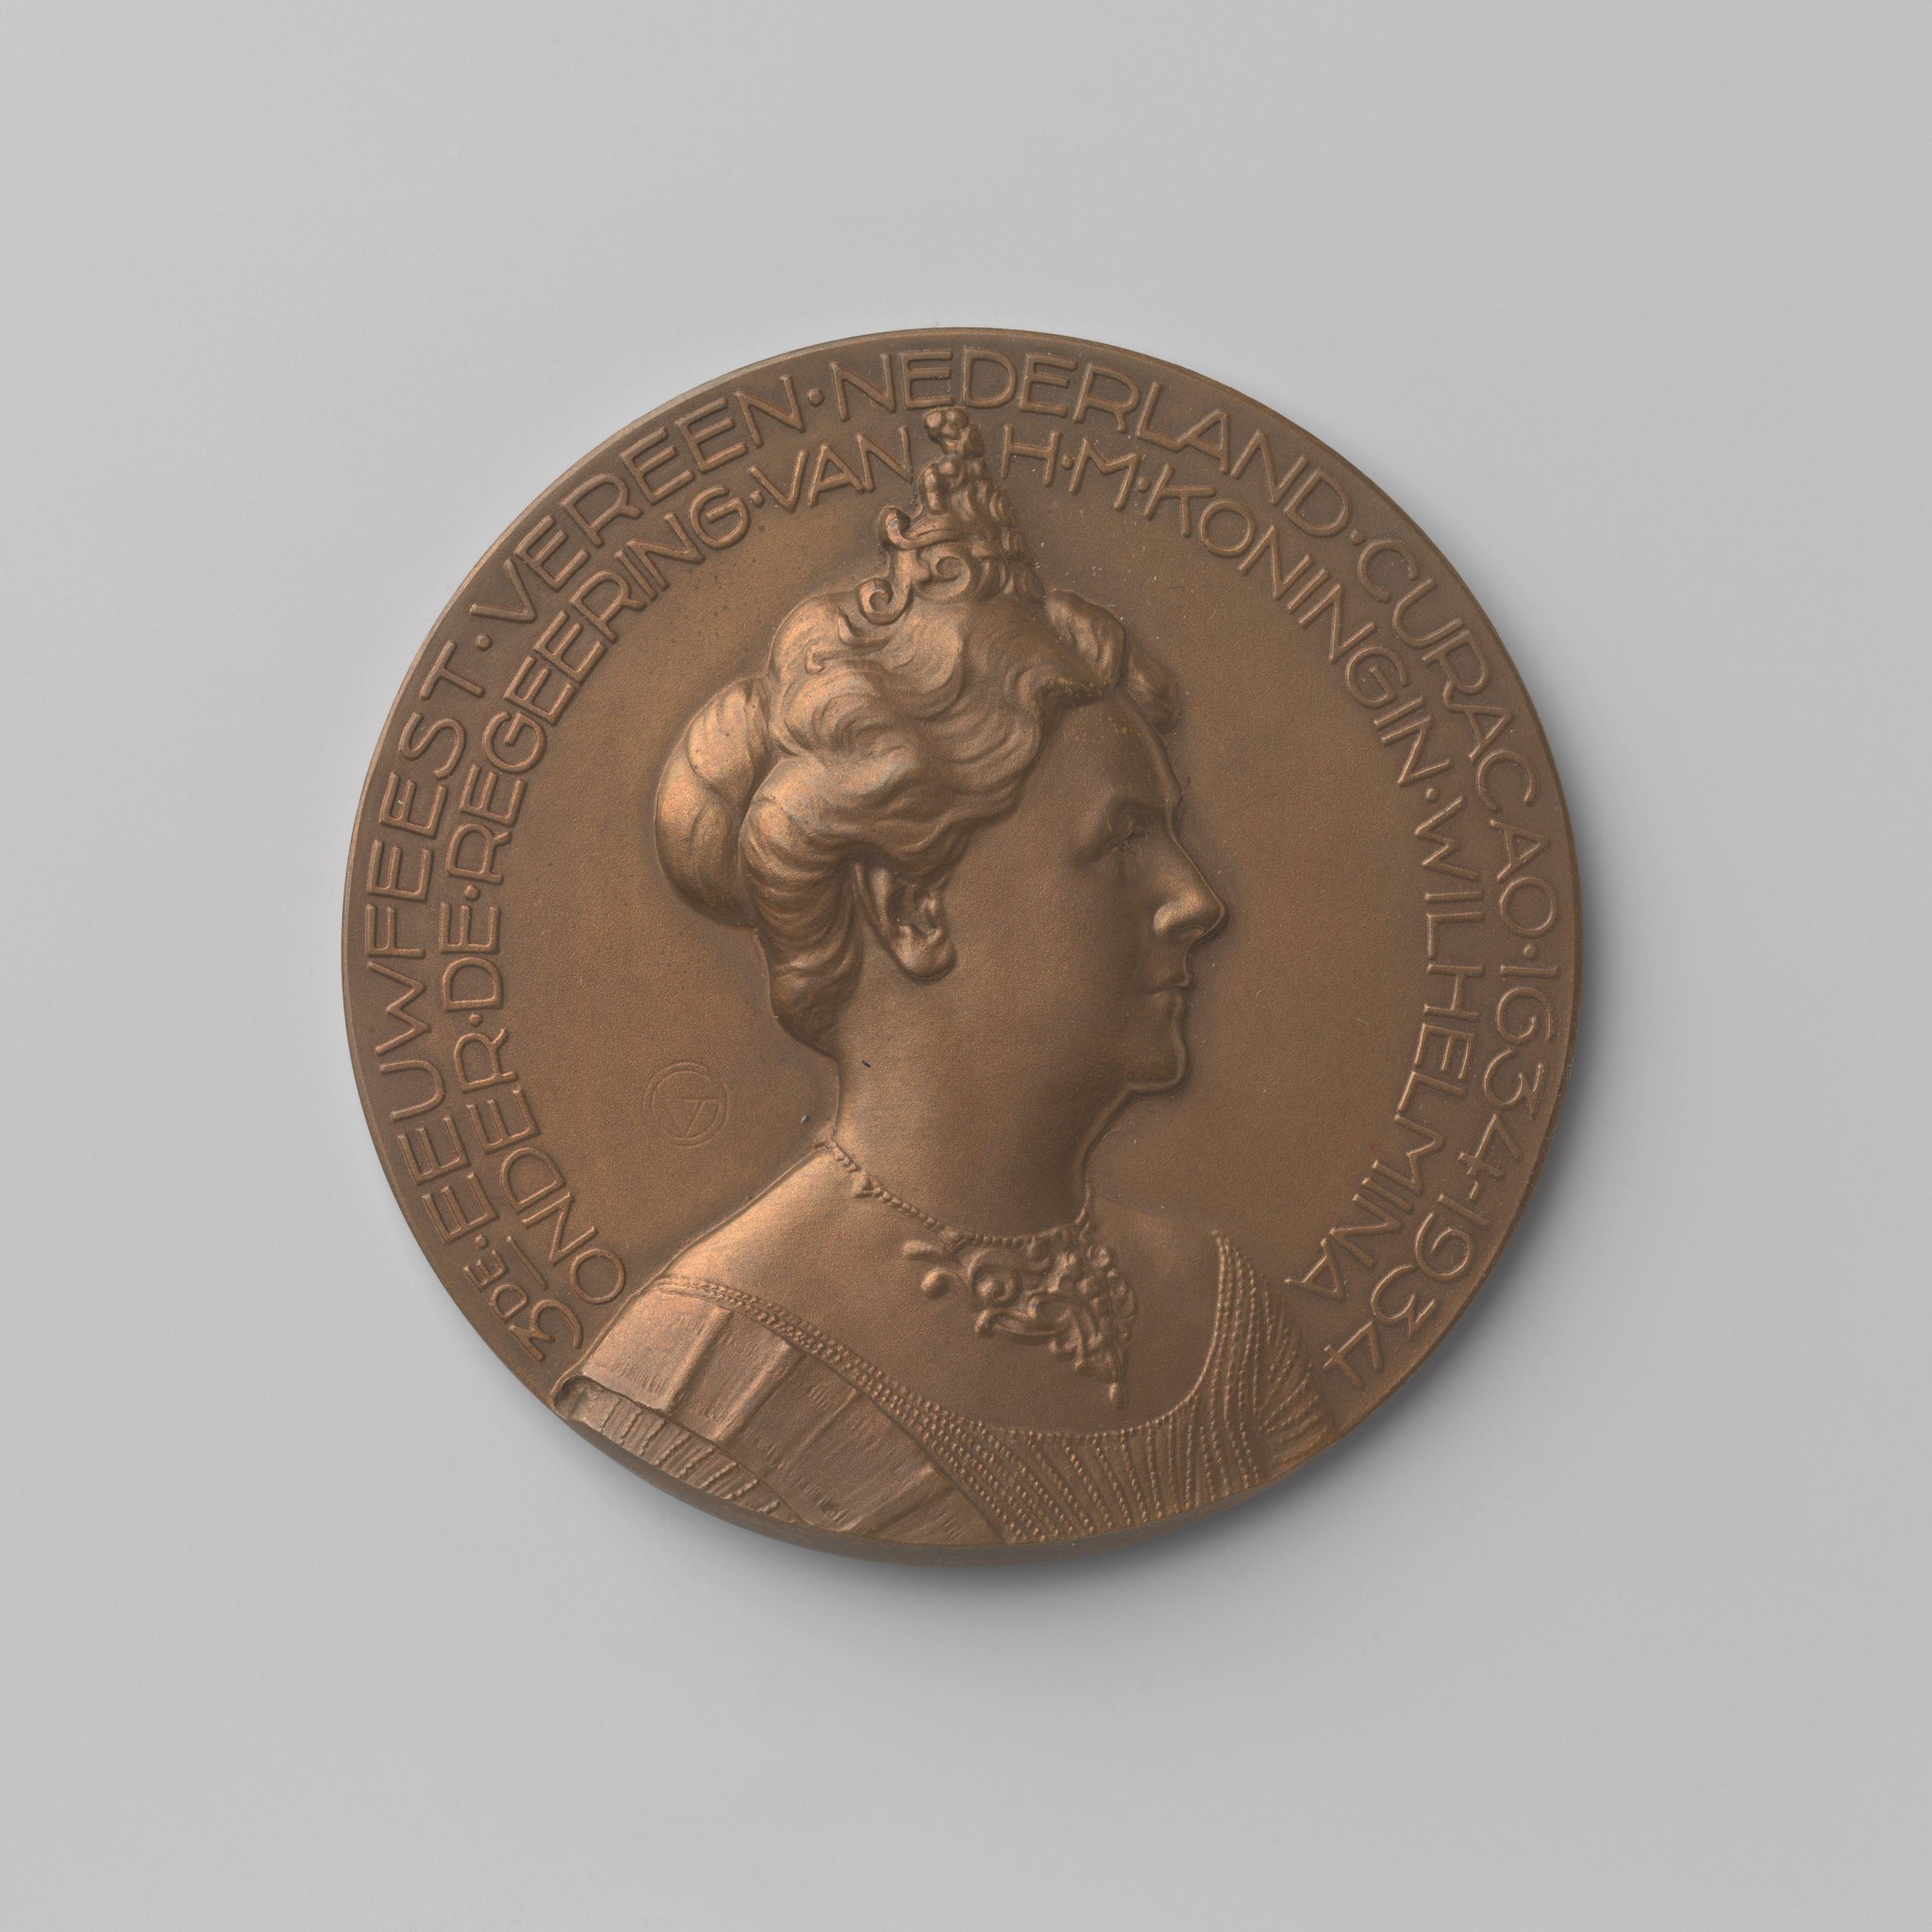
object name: history medal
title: Driehonderdjarige relatie Nederland-Curacao 1934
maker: jacob jan van goor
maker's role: medailleur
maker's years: 1874-1956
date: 1934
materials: bronze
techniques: striking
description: Bronzen penning, op de voorzijde het borstbeeld van Koningin Wilhelmina naar rechts met twee regels omschrift, op de keerzijde een driemaster op zee naar links met omschrift.